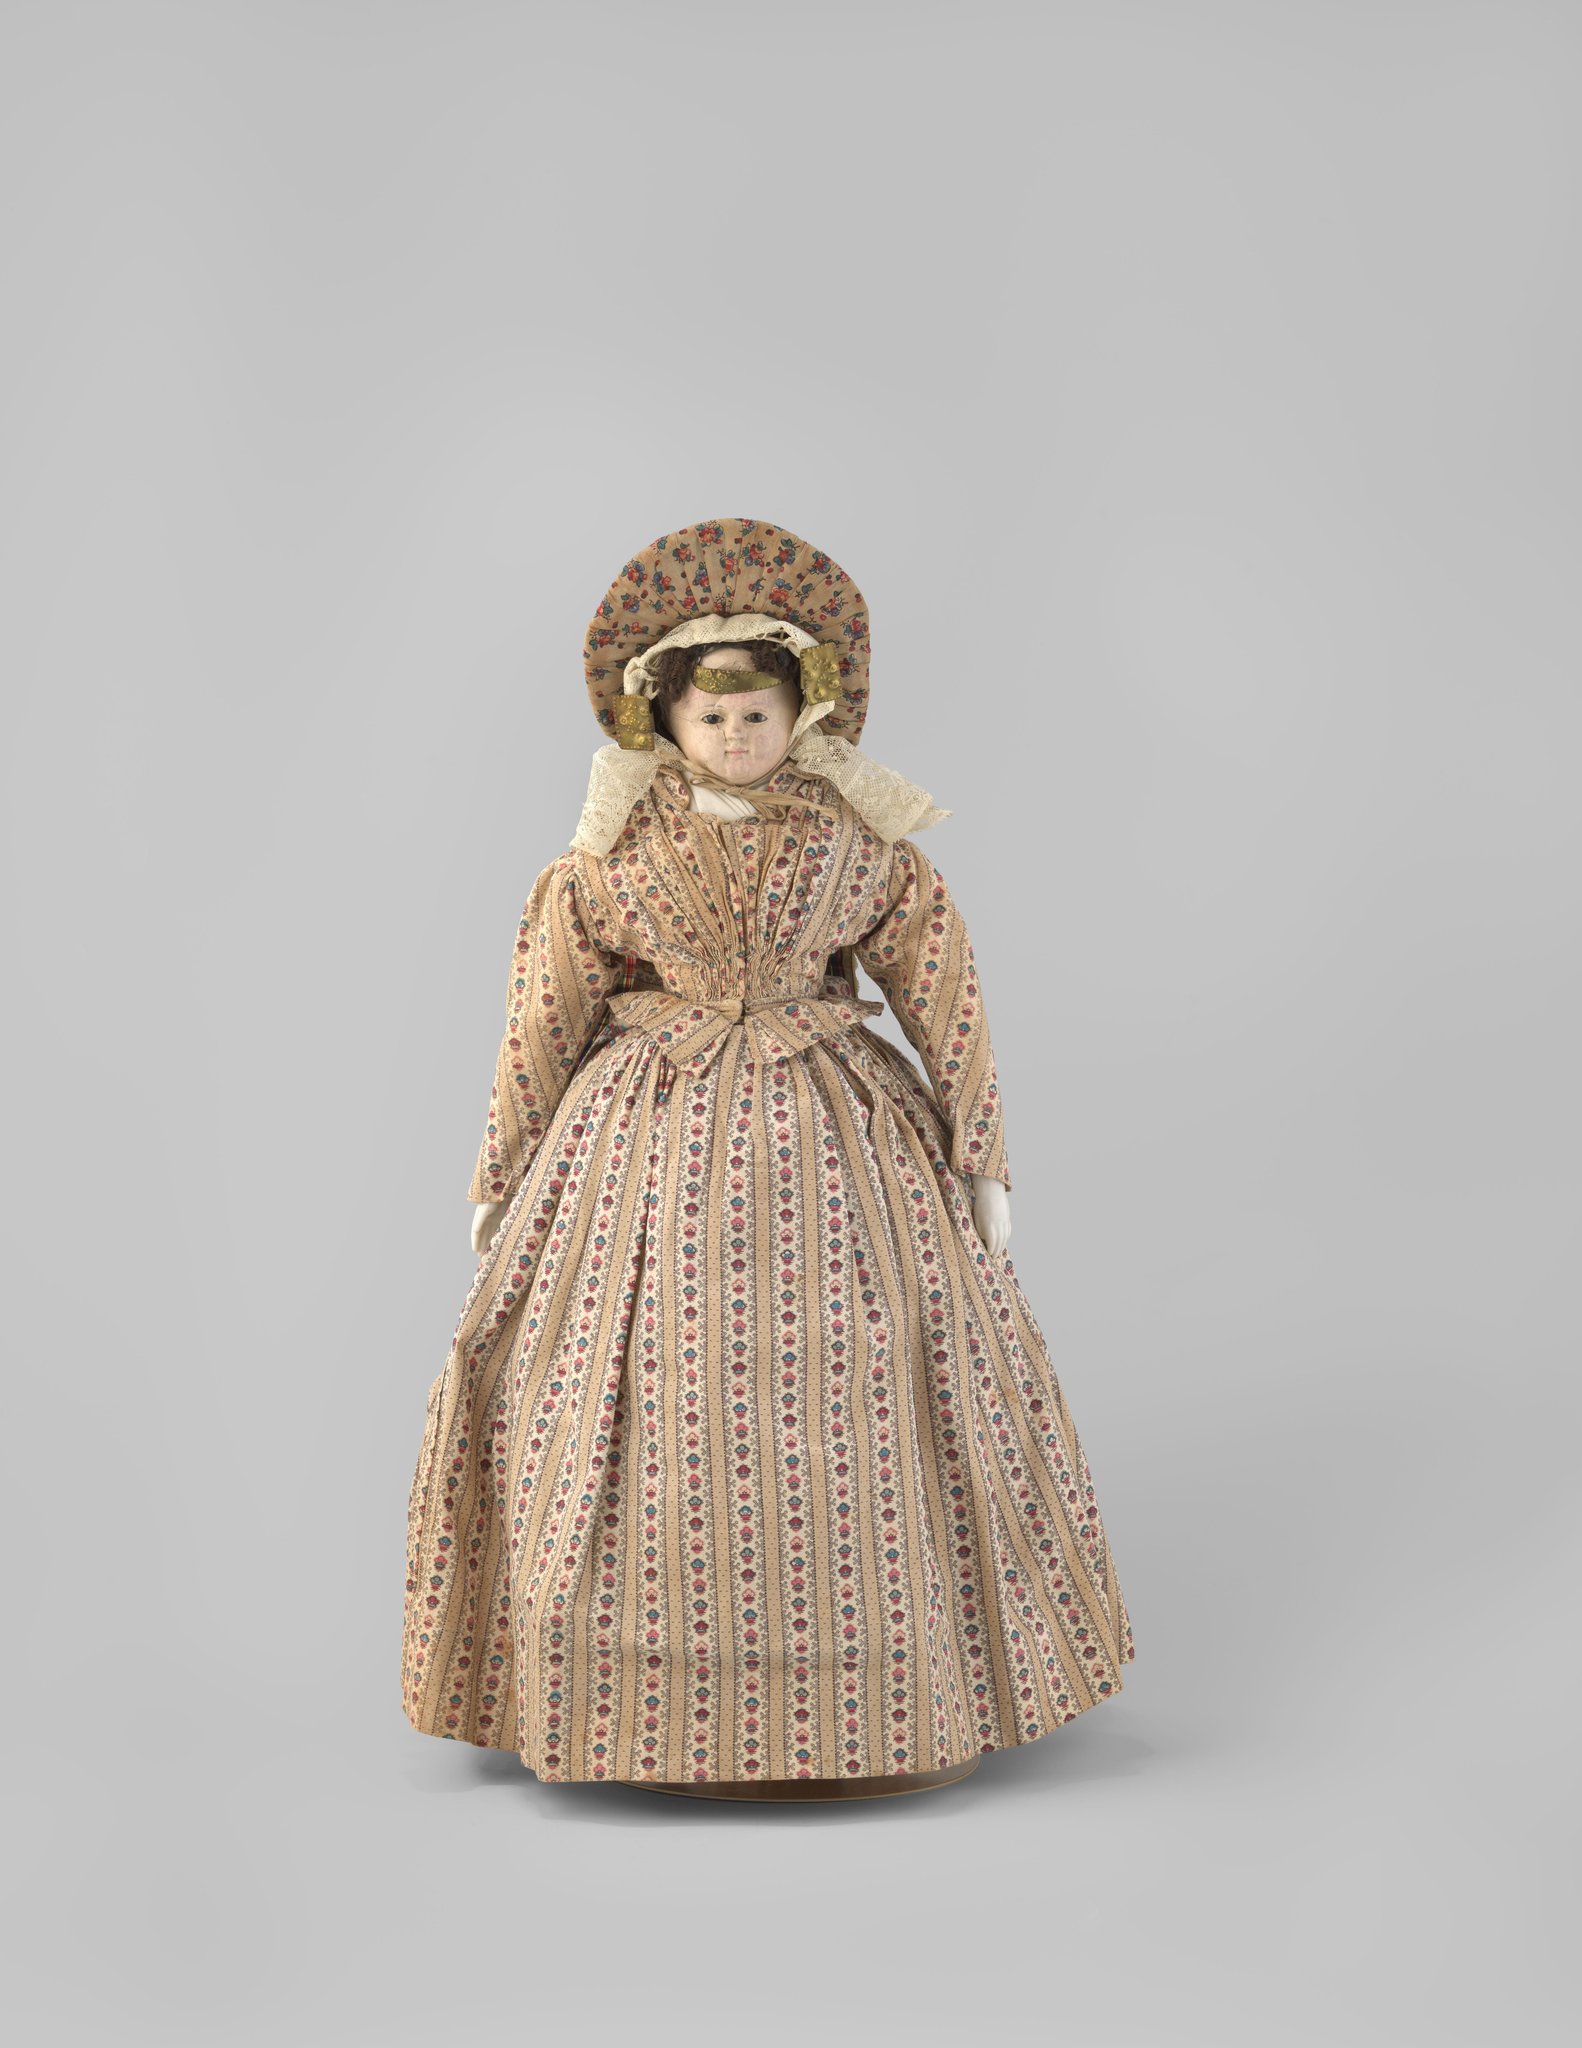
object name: doll's clothing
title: Pop in streekdracht. Luifelhoed van stro, kap van kant en oorijzers. Rok en lijf van gebloemde katoen, zwarte wollen schort en een paarse katoenen cape en een zwarte van laken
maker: Anonymous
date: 1840-1860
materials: porcelain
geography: netherlands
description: Pop in streekdracht. Luifelhoed van stro, kap van kant en oorijzers. Rok en lijf van gebloemde katoen, zwarte wollen schort, paars katoenen cape en een cape van zwart laken.